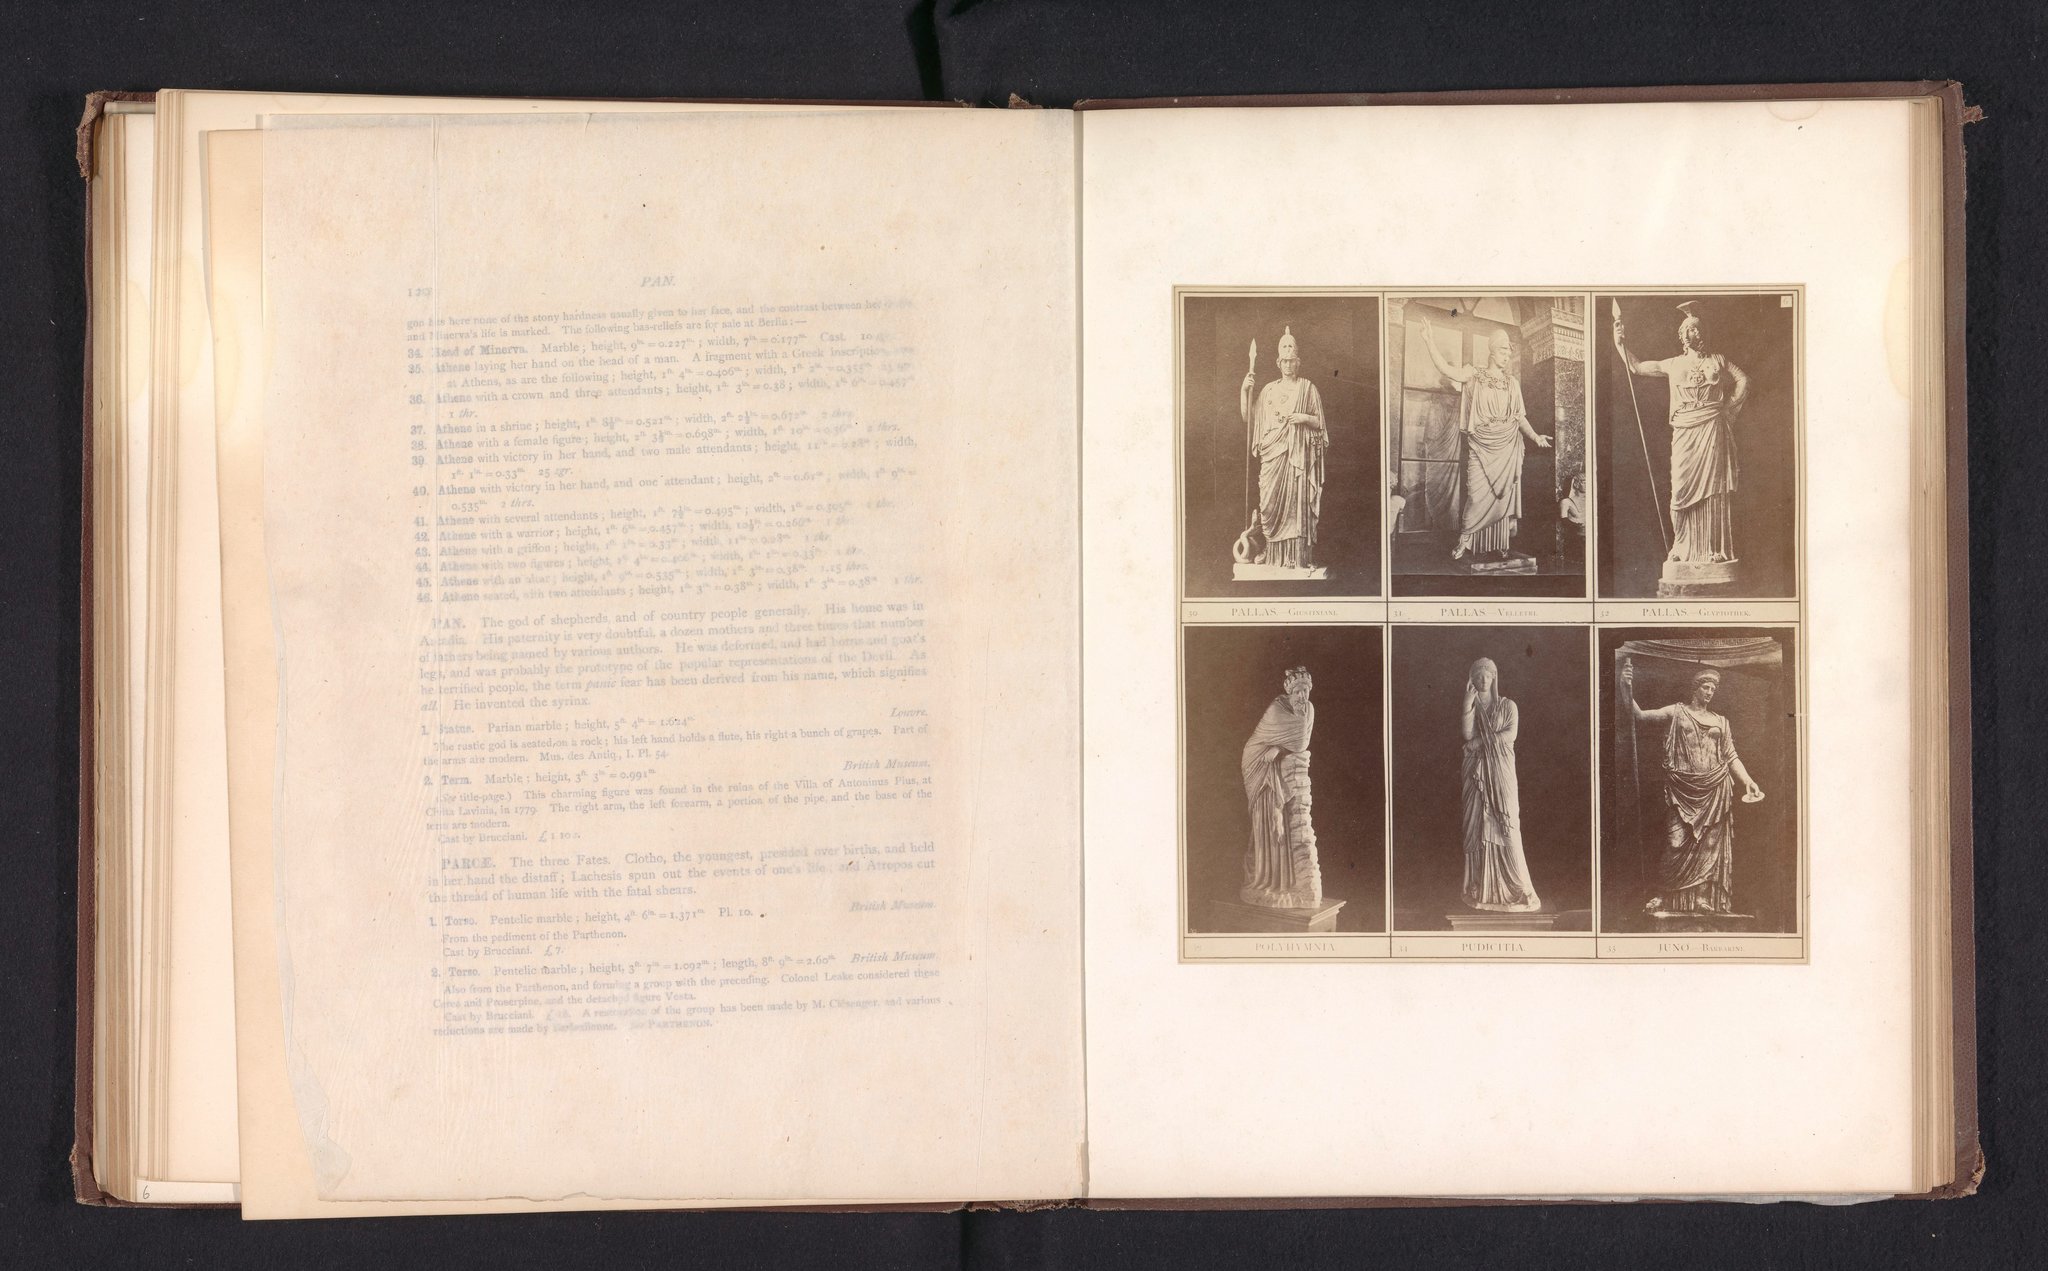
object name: page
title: Zes afgietsels van antieke sculpturen van vrouwen waaronder Pallas Athena en Juno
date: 1864-1874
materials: photographic support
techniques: albumen print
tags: (story of) juno (hera), (story of) minerva (pallas, athena), piece of sculpture, reproduction of a piece of sculpture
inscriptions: inscription: ‘30 Pallas Giustiniani. 31 Pallas Velletri. 32 Pallas Glyptothek. 33 Polyhymnia. 34 Pudicitia. 35 Juno Barbarini.’